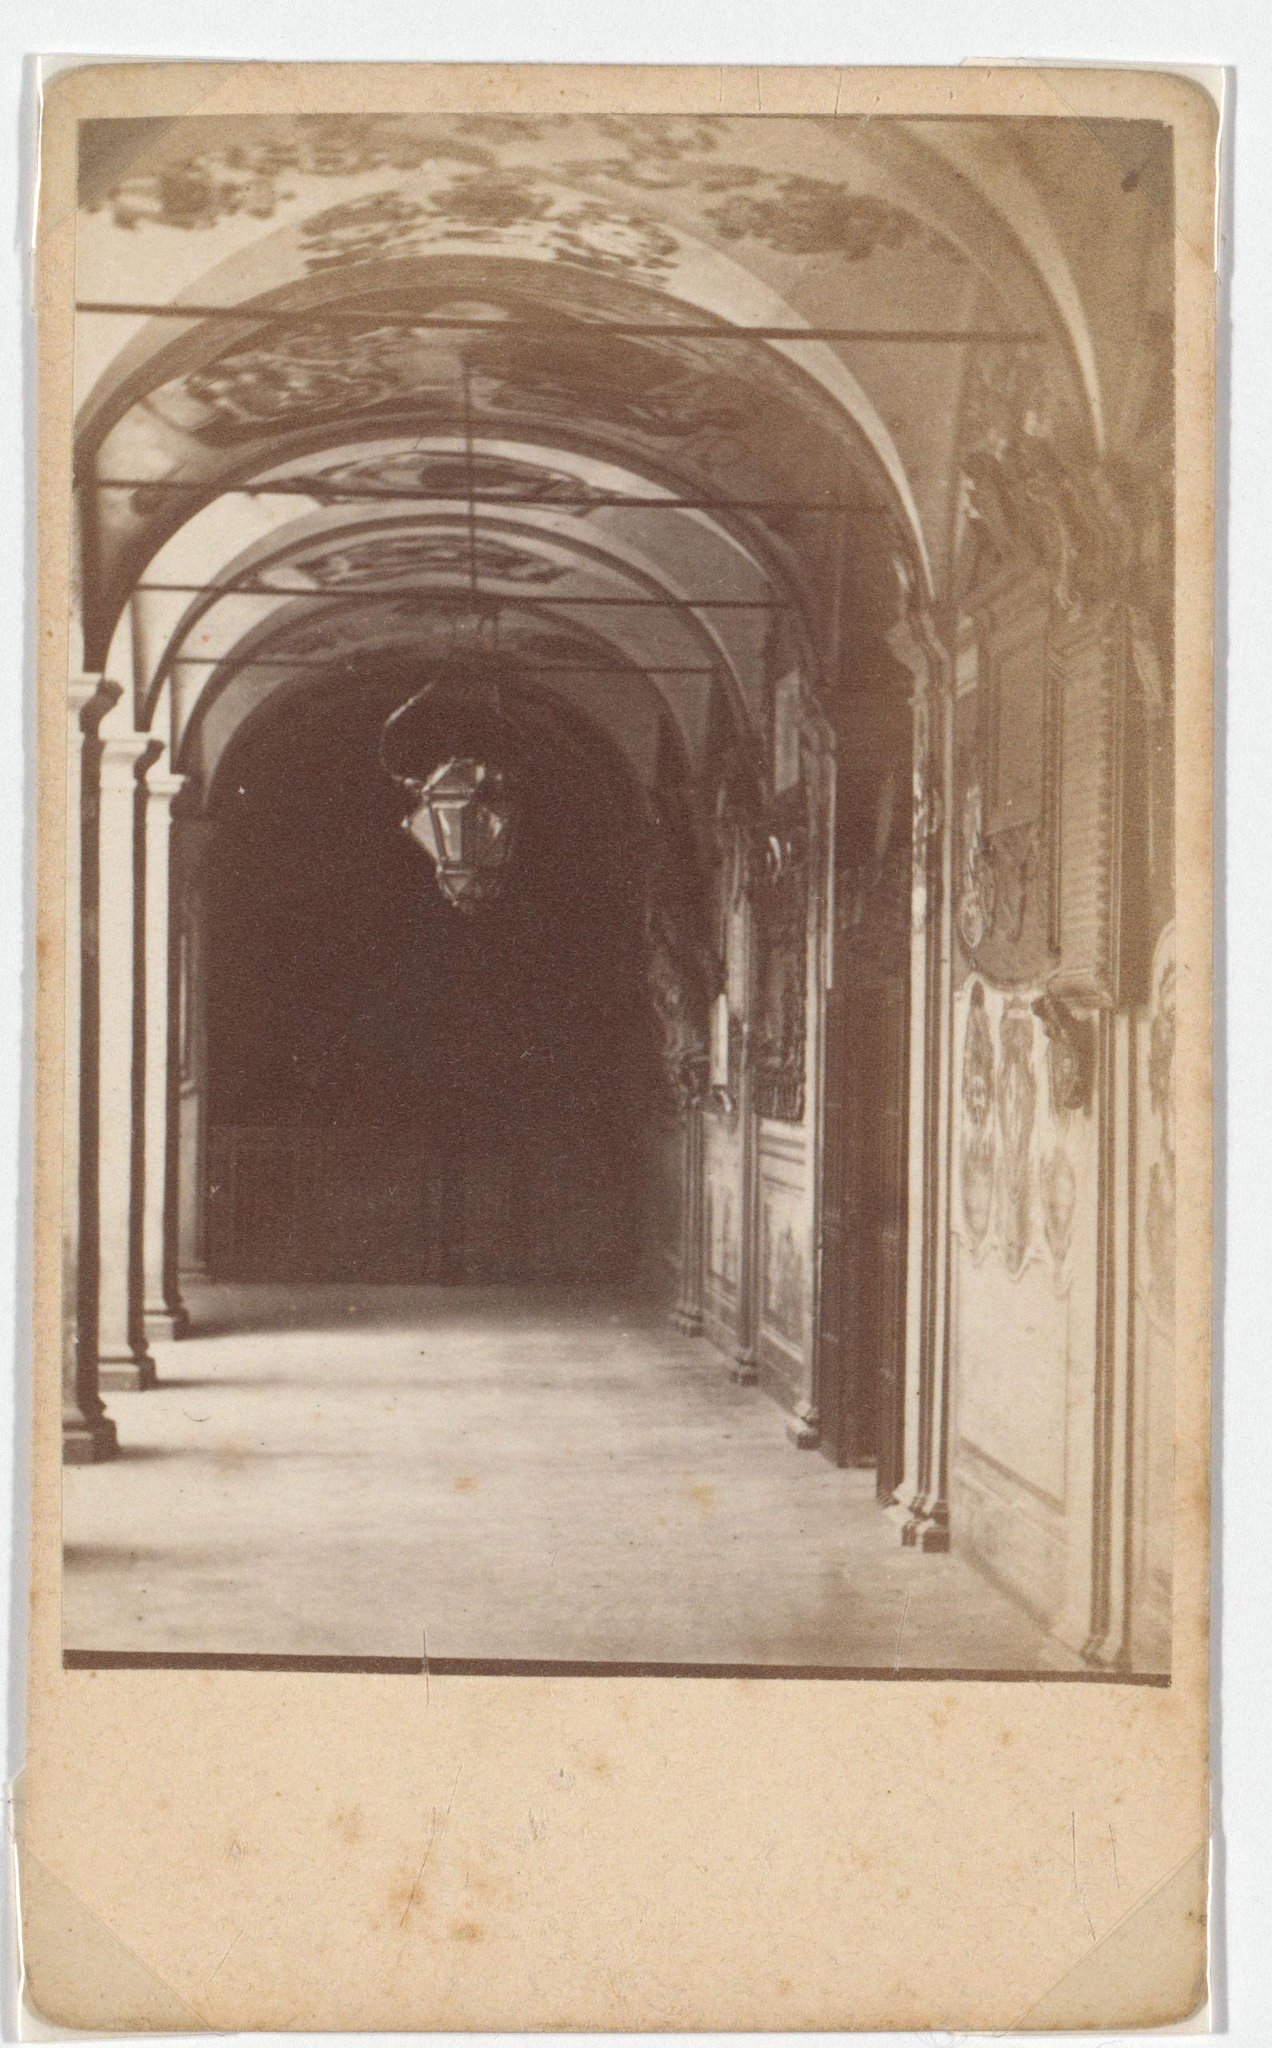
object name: photograph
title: Portico, vermoedelijk in Bologna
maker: emilia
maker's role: fotograaf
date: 1860-1880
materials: cardboard, paper, photographic support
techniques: albumen print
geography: italy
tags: colonnade, italy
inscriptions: address: ‘Strada S. Mamolo No. 101 Palazzo Rodriguez Bologna’